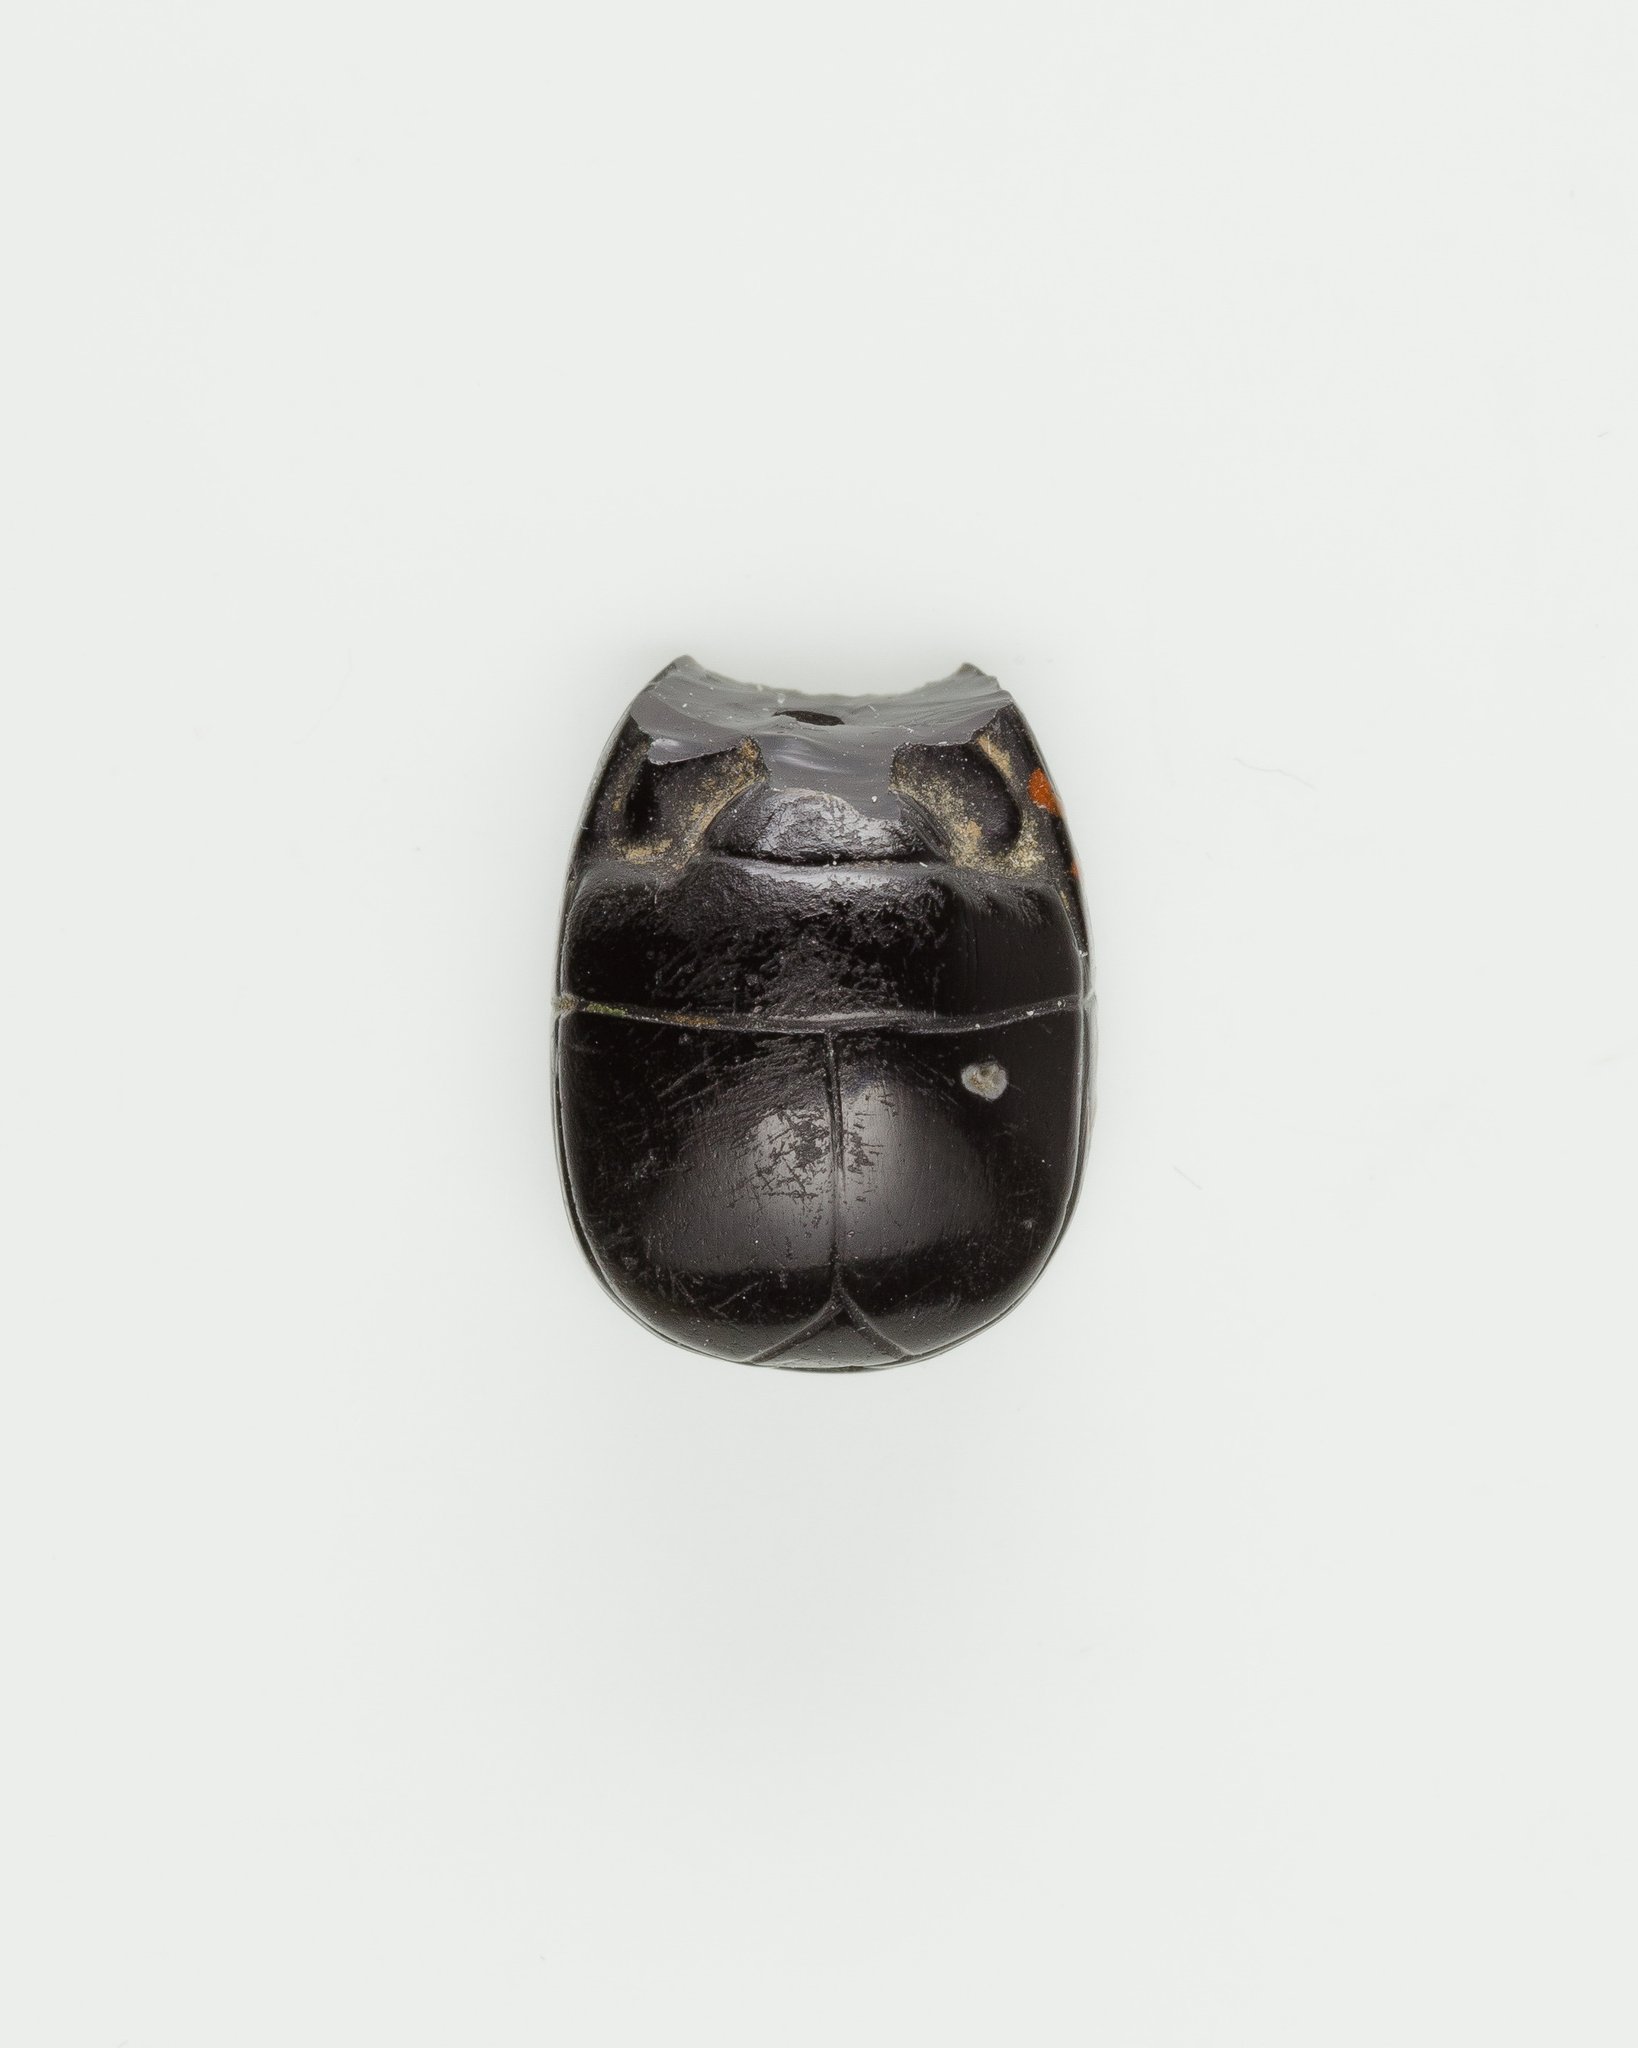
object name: scarab, hieroglyph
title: Scarab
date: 1981-1640 BCE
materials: obsidian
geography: egypt